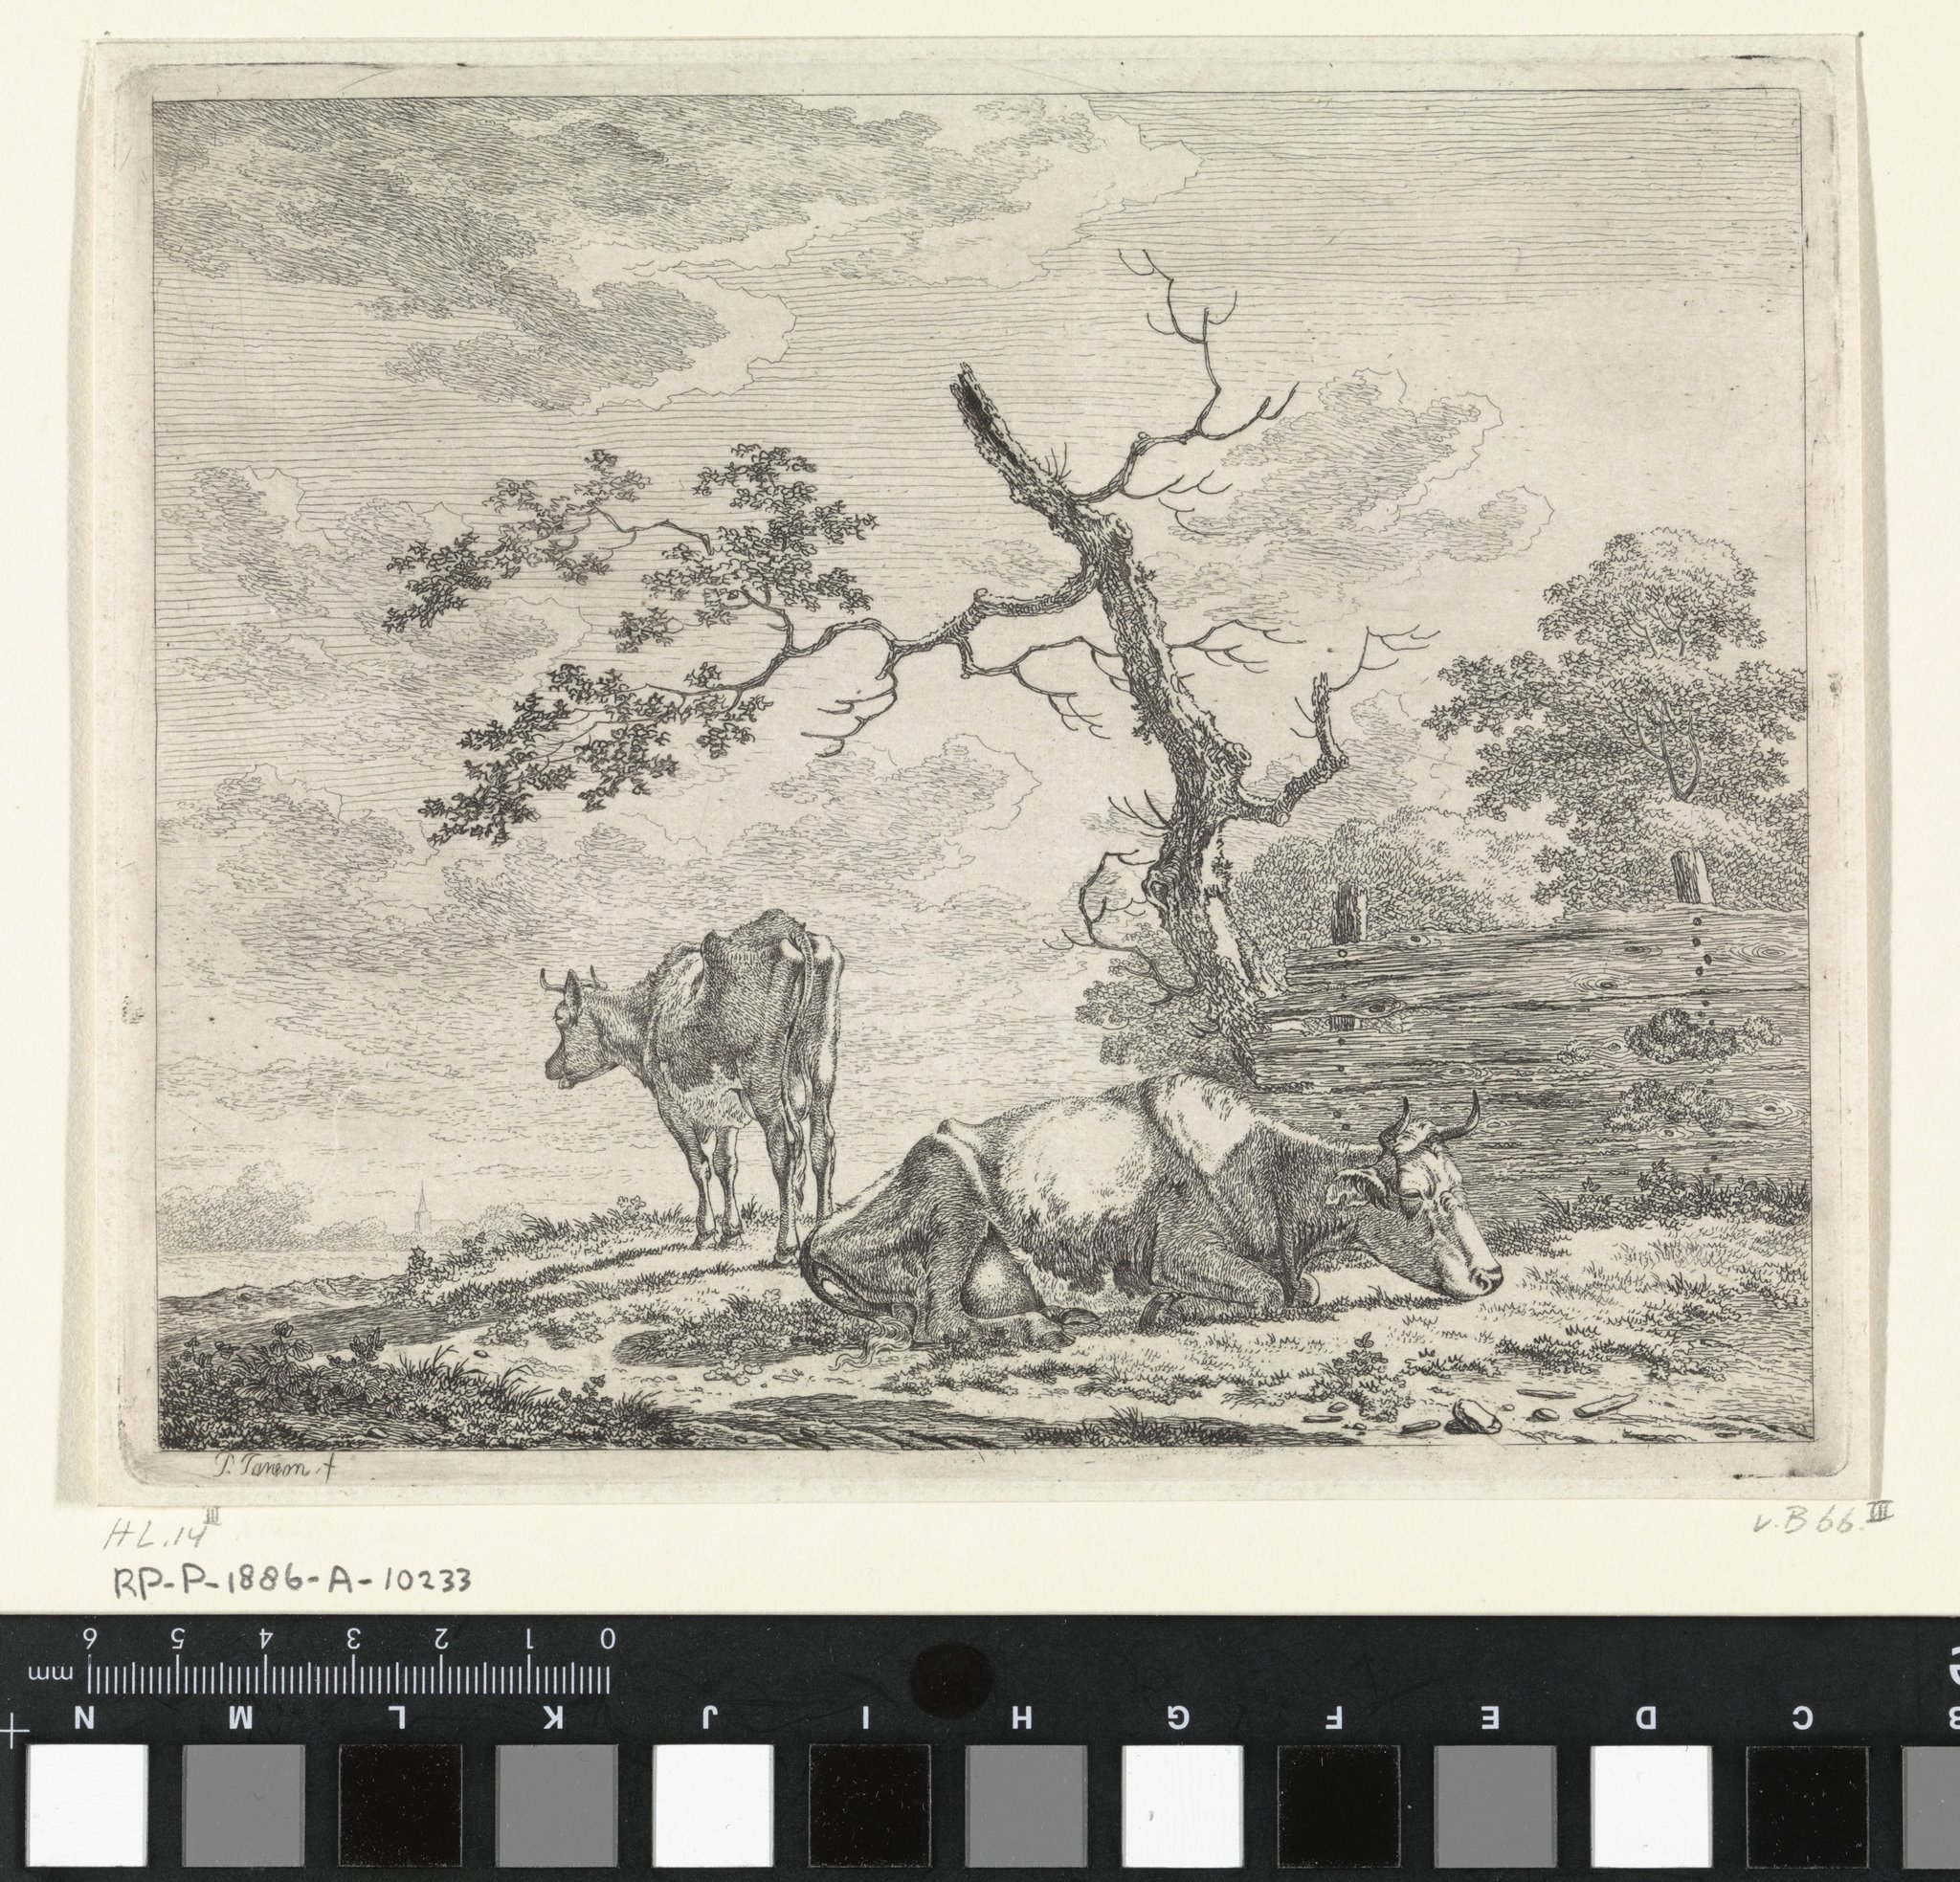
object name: print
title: Twee koeien bij hek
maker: pieter janson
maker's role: draughtsman, print maker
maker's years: 1765-1851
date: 1780-1851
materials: paper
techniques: etching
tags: cow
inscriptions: collector's mark: Lugt 2228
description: Landschap met twee koeien bij een hek met daarachter een boom. Eén liggend, de ander staand, van achter gezien. Mét de lucht.